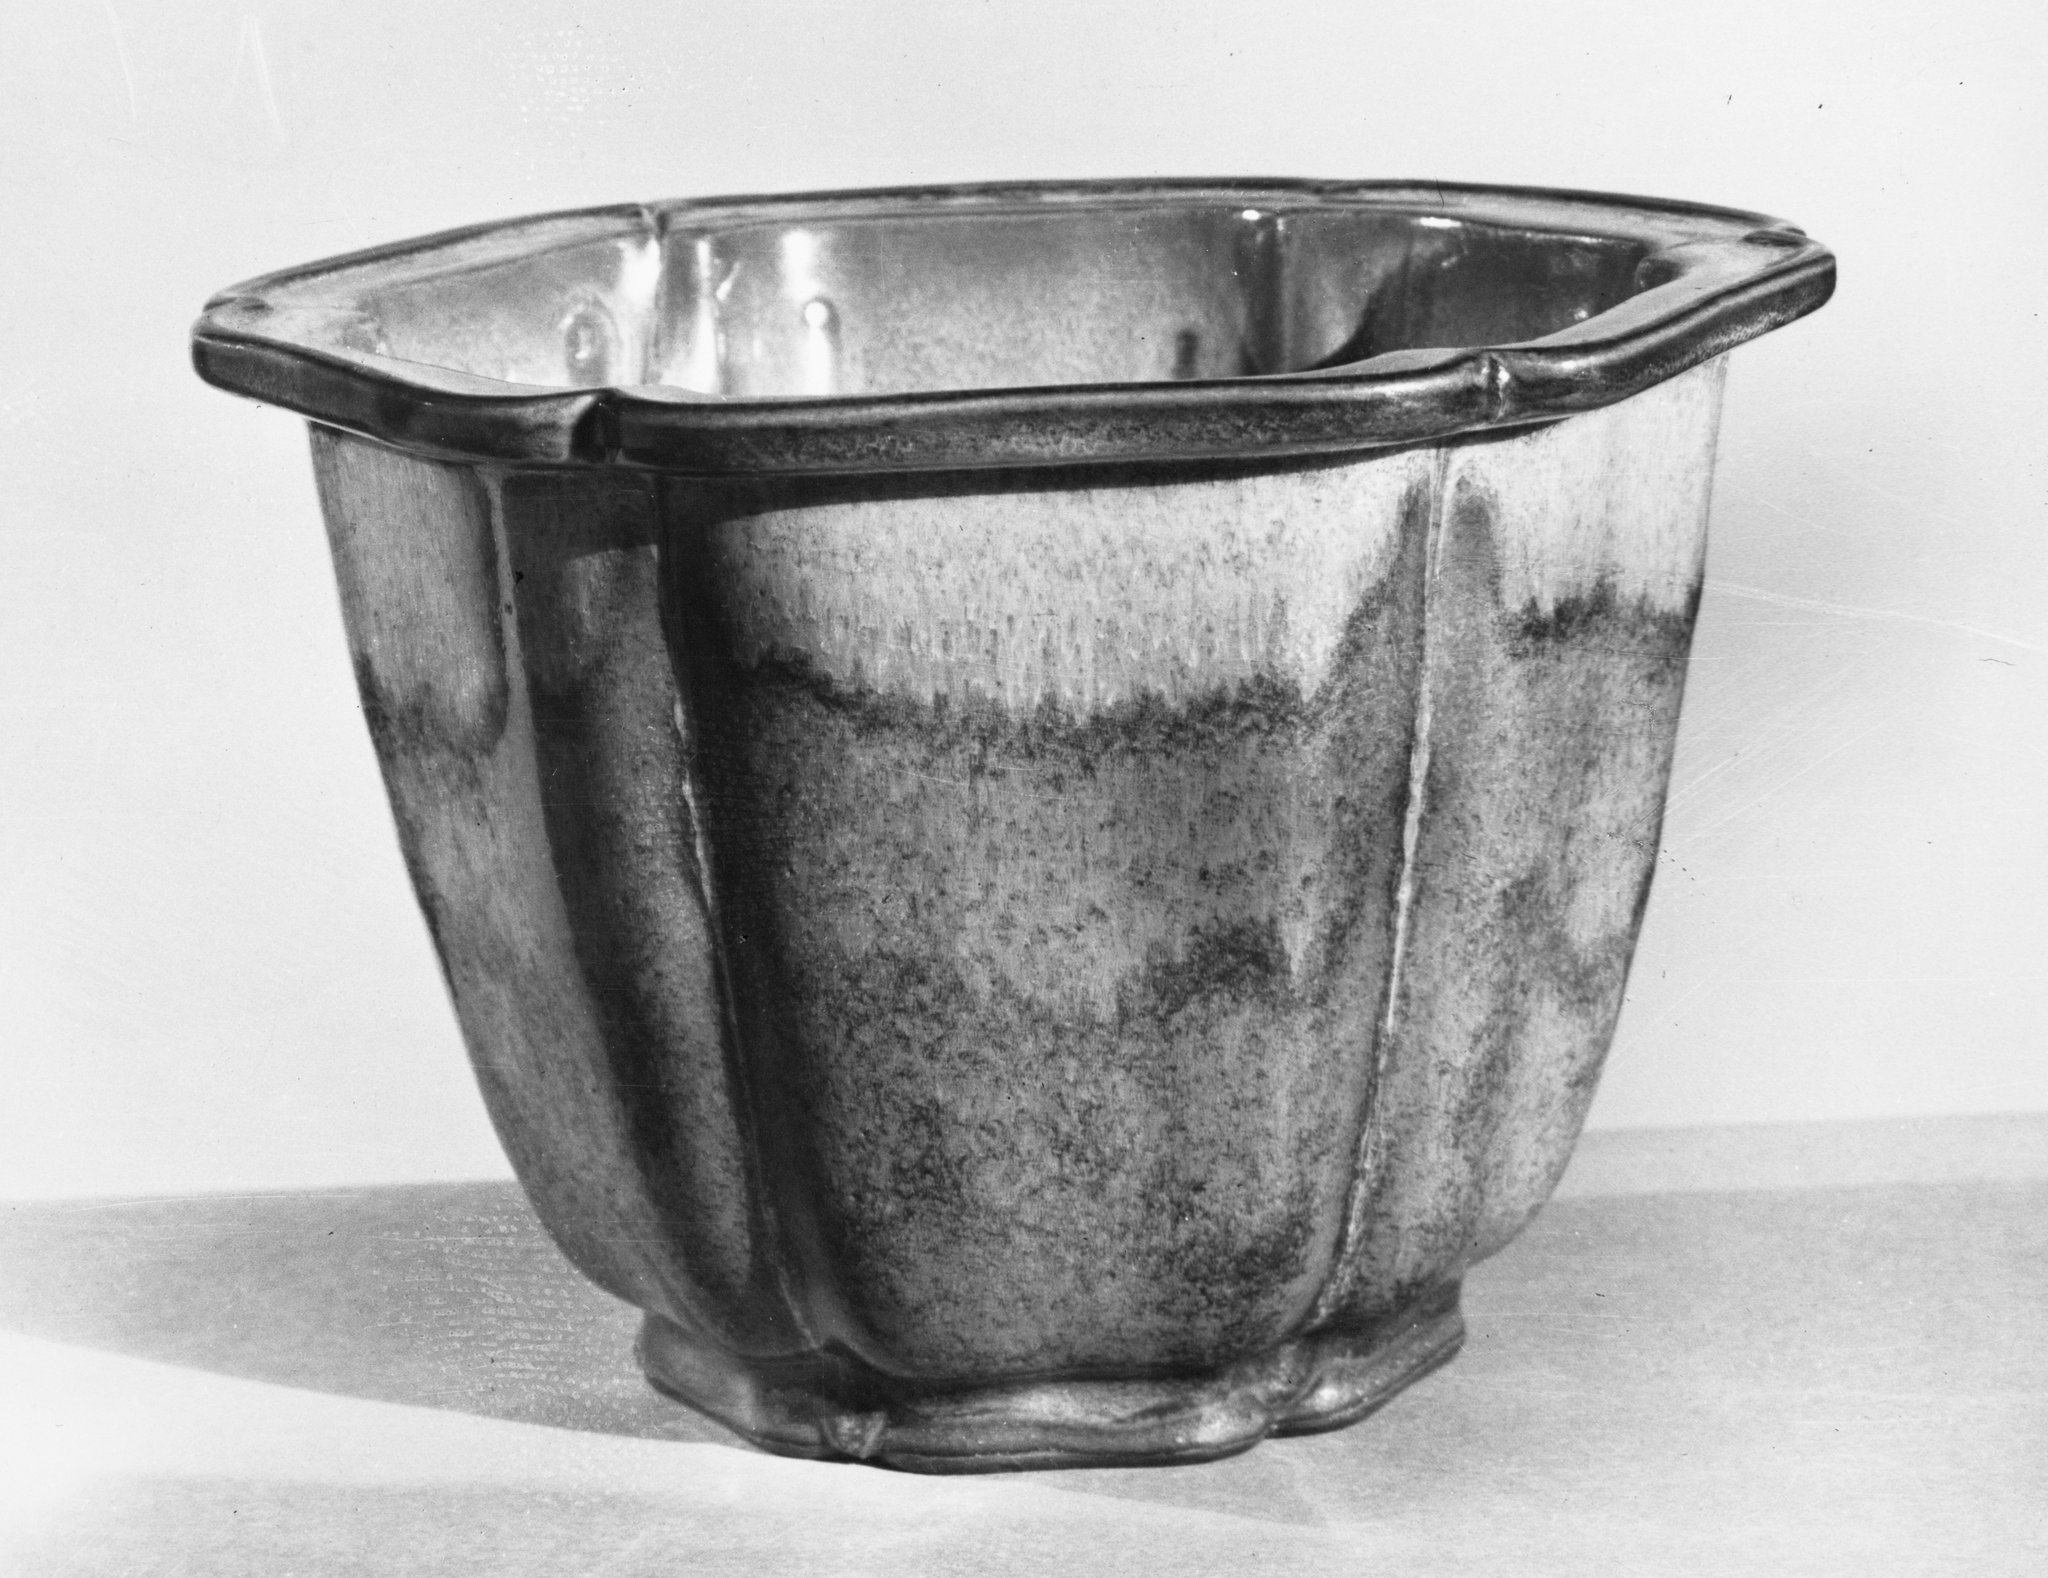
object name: flower pot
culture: chinese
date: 1201-1400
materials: glaze, stoneware